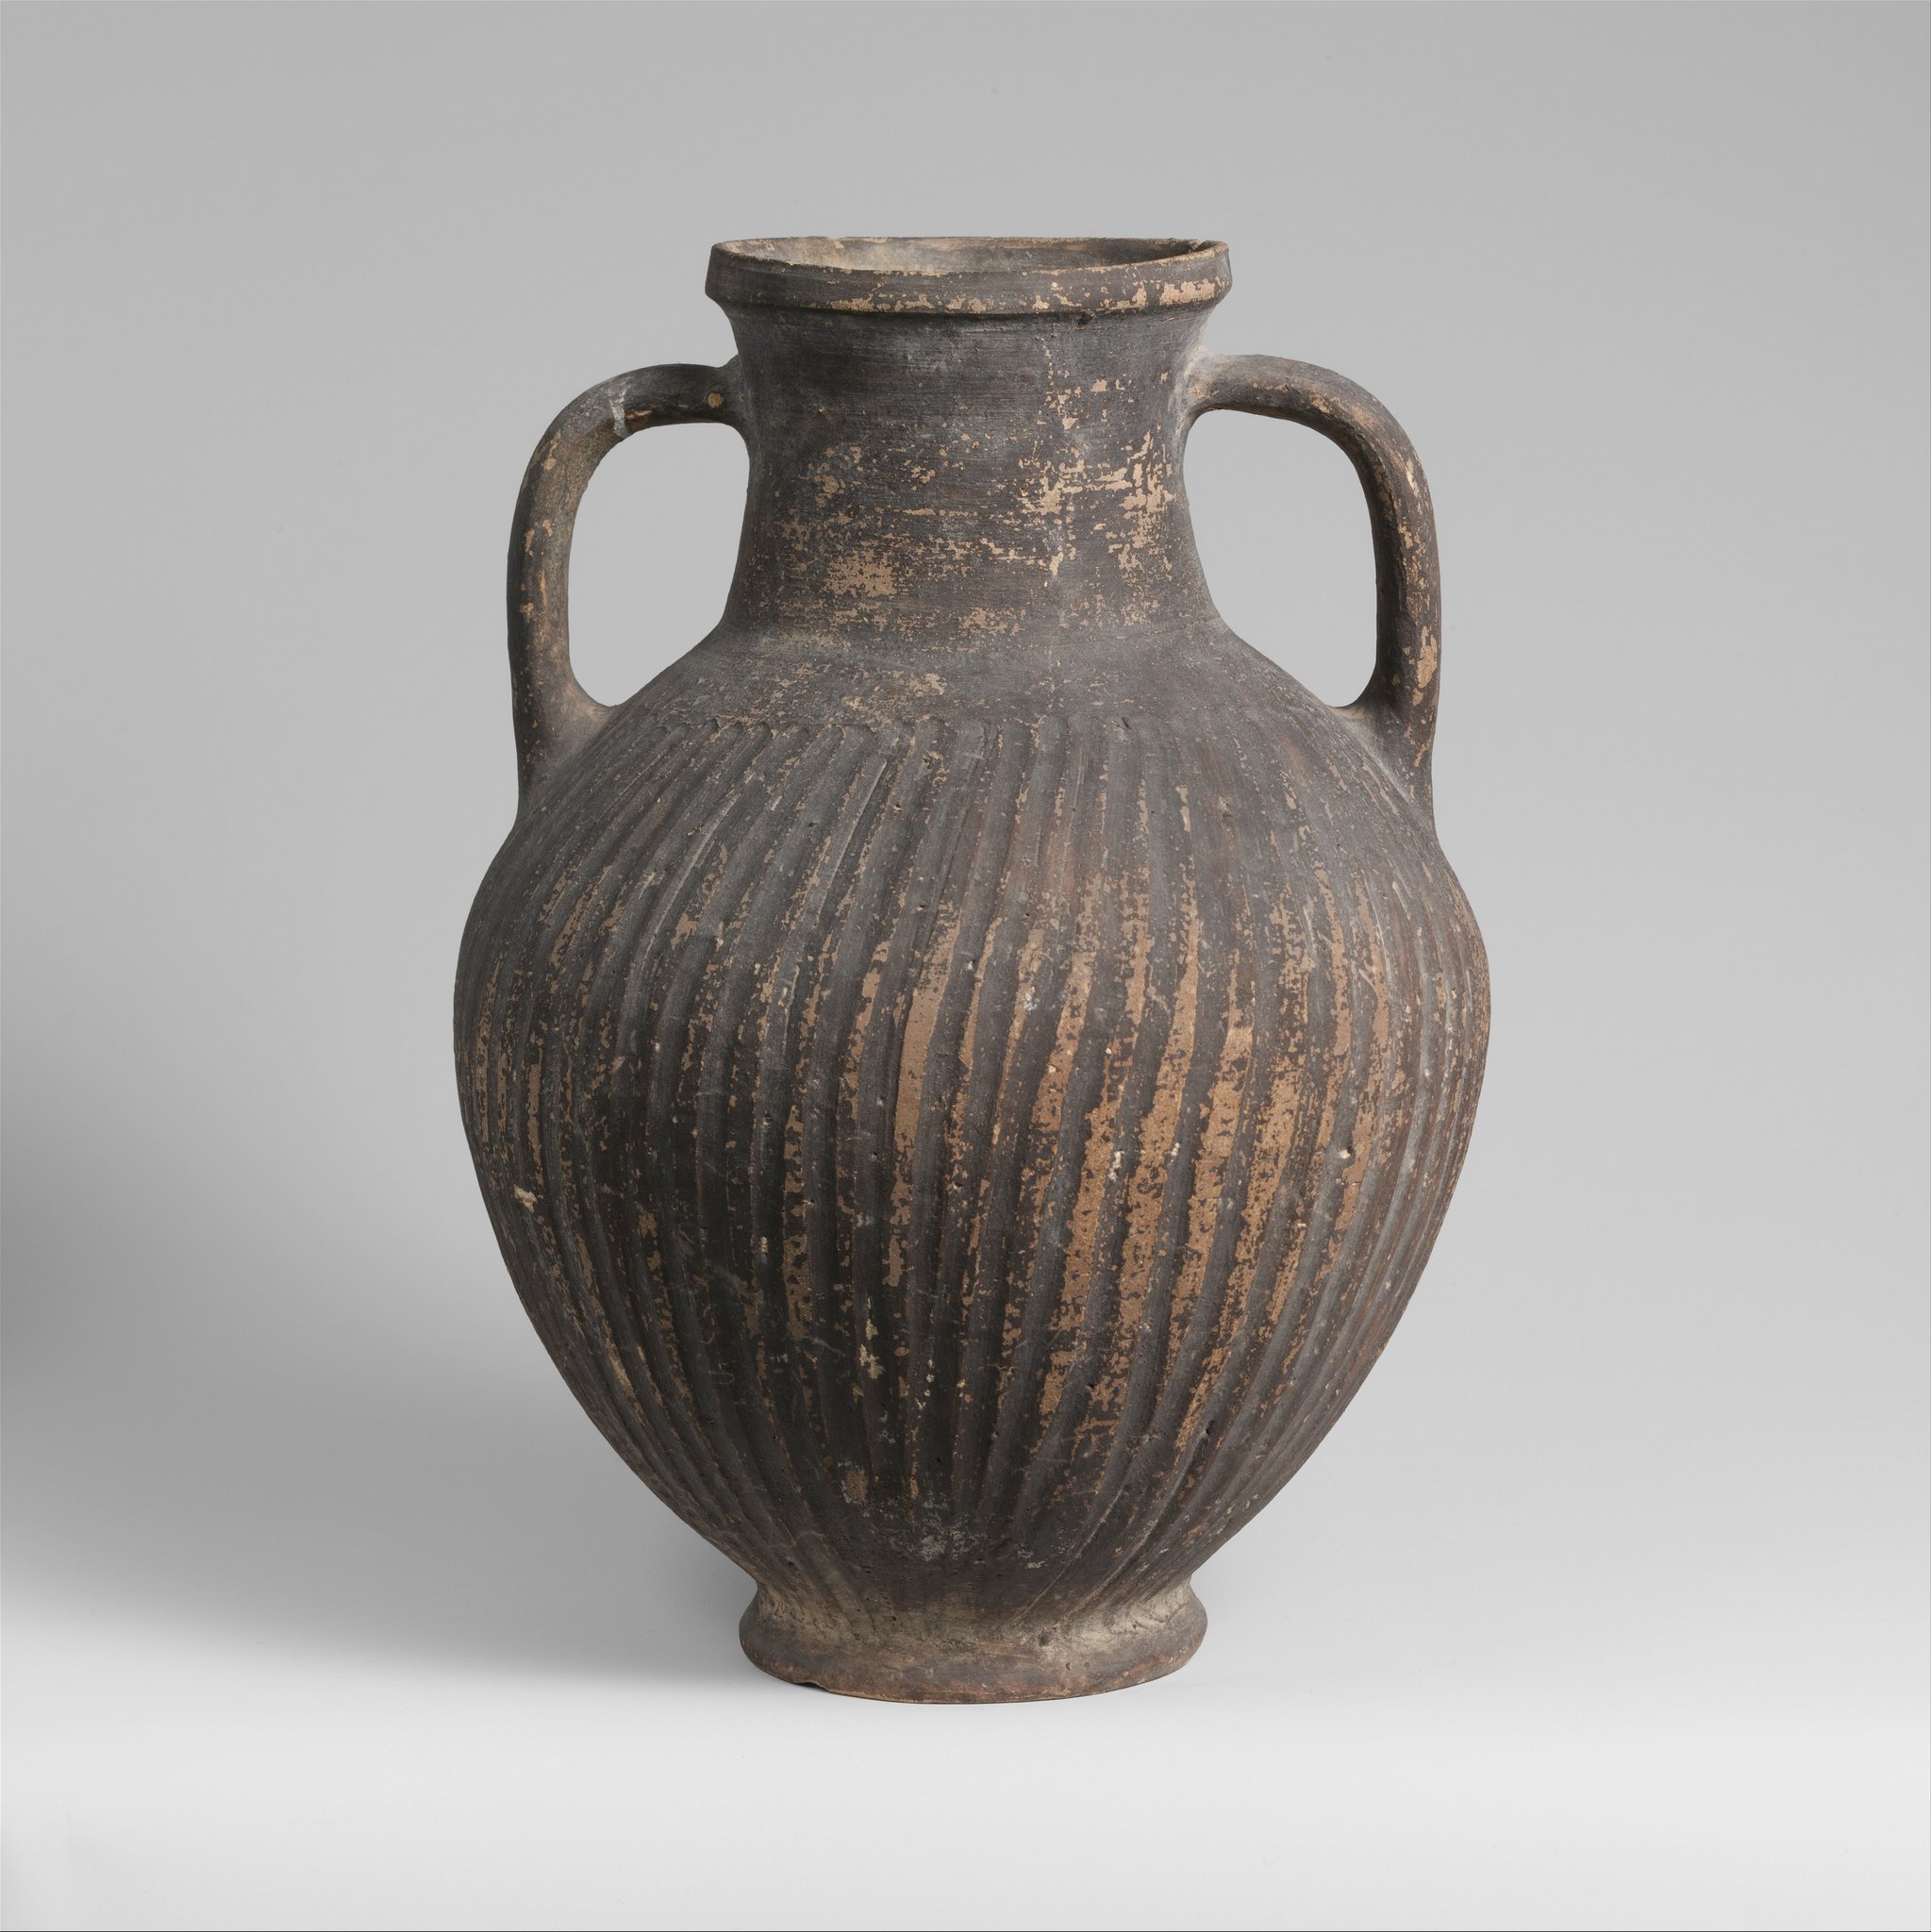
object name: amphora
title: Terracotta amphora (jar)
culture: cypriot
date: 1050-950 BCE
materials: terracotta